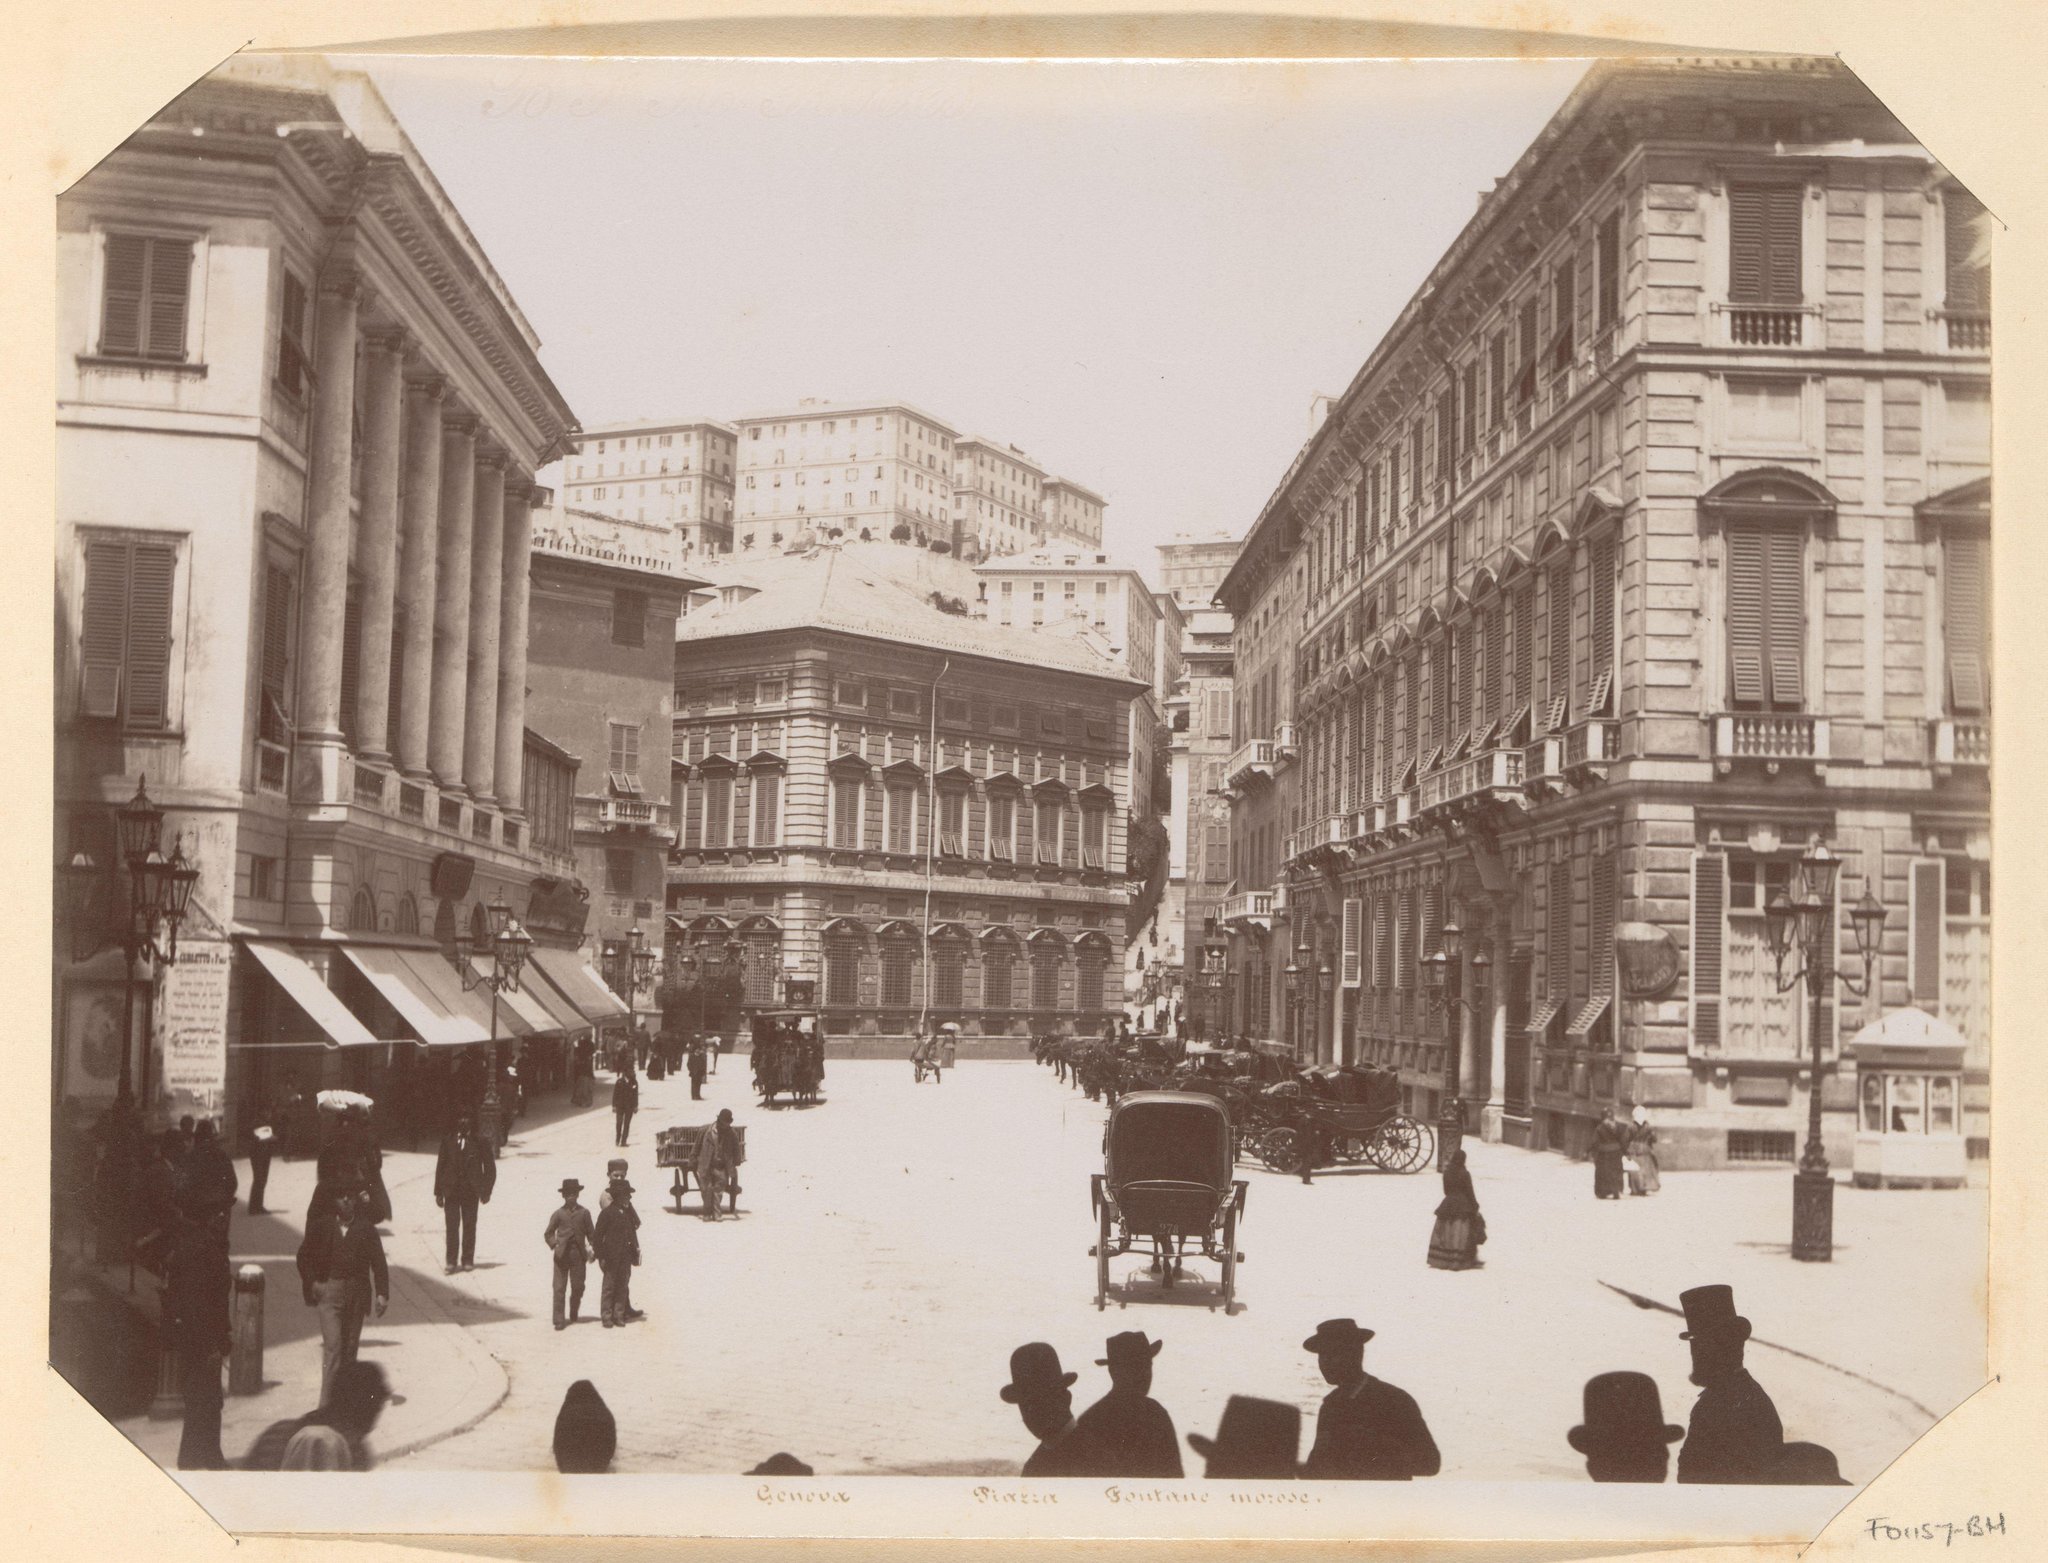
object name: photograph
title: Genova. Piazza Fontane morose.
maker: Anonymous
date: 1885-1892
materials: photographic support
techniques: albumen print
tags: square, place, circus, etc., two-wheeled, animal-drawn vehicle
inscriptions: annotation: ‘Genua - Piazza Fontane Morose’